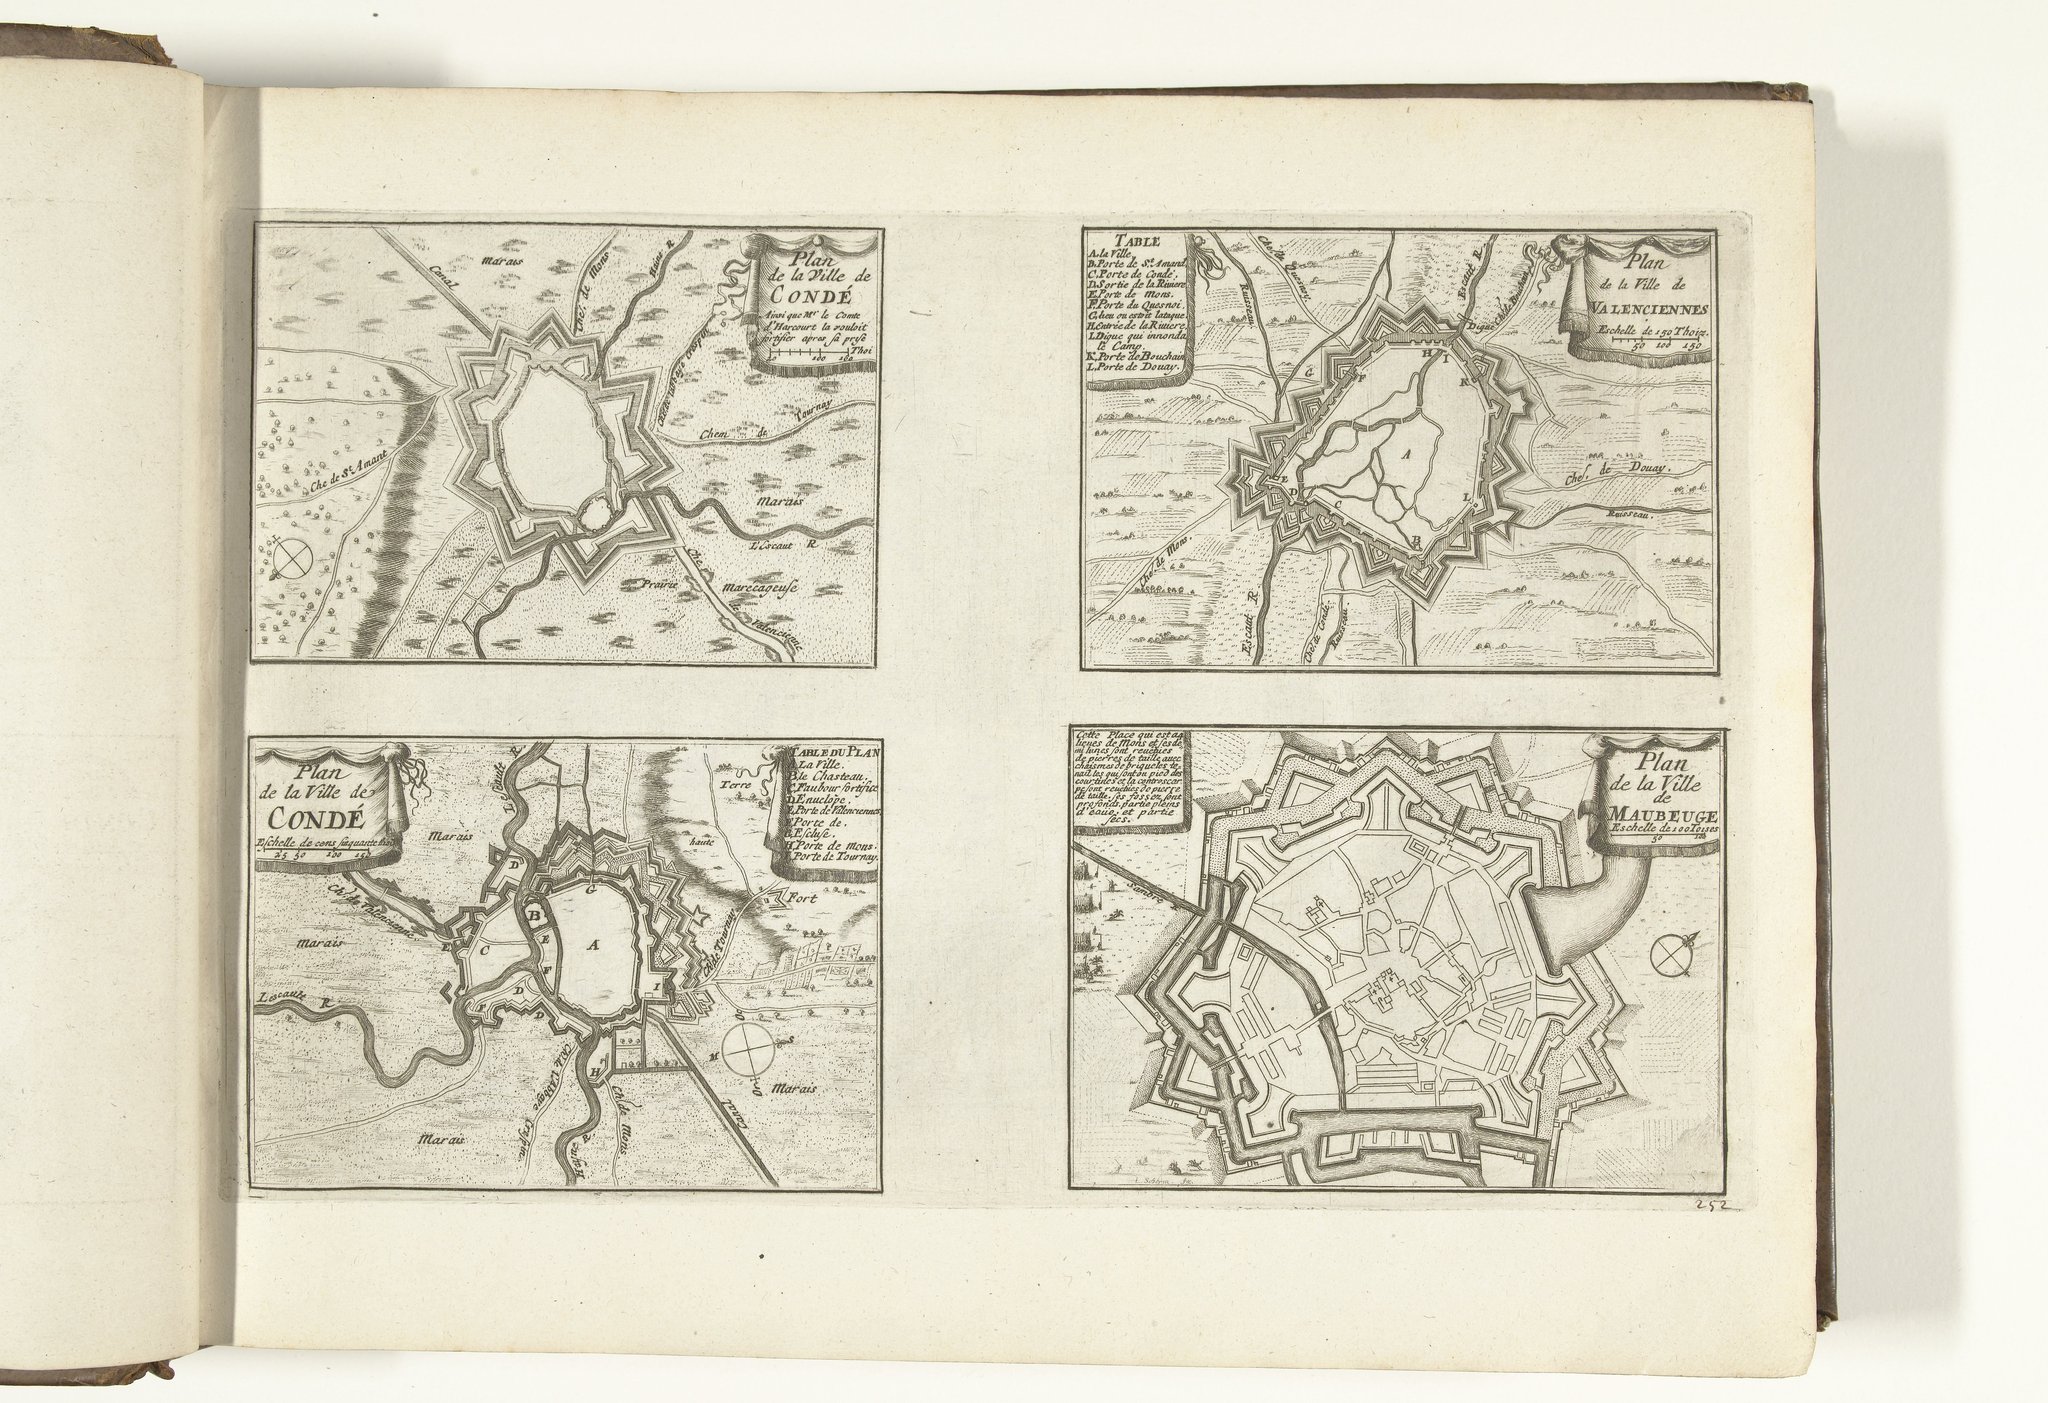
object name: map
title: Condé / Valenciennes / Condé / Maubeuge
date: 1726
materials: paper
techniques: engraving, etching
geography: leiden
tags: fortress, maps of cities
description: Blad met vier plattegronden van de versterkingen om de steden Condé (twee keer), Valenciennes en Maubeuge. Plaat nr. 252 in deel XI van het prentwerk: Les Forces de l'Europe, Asie, Afrique et Amerique ... Comme aussi les Cartes des Côtes de France et d'Espagne uit 1726, dit tweede deel met 271 met de hand genummerde platen van vermaarde sterke steden en vestingen in het kader van de Spaanse Successieoorlog 1701-1713. Voor het merendeel zijn deze platen gekopieerd naar de anonieme Franse platen van vermaarde sterke steden en vestingen: in Les forces de l'Europe en in: Le theatre de la guerre, dans les Pays-Bas, beide oorspronkelijk uitgegeven door Nicolas de Fer te Parijs (1693-1697) in het kader van de Negenjarige Oorlog. Titels en opschriften in het Frans.